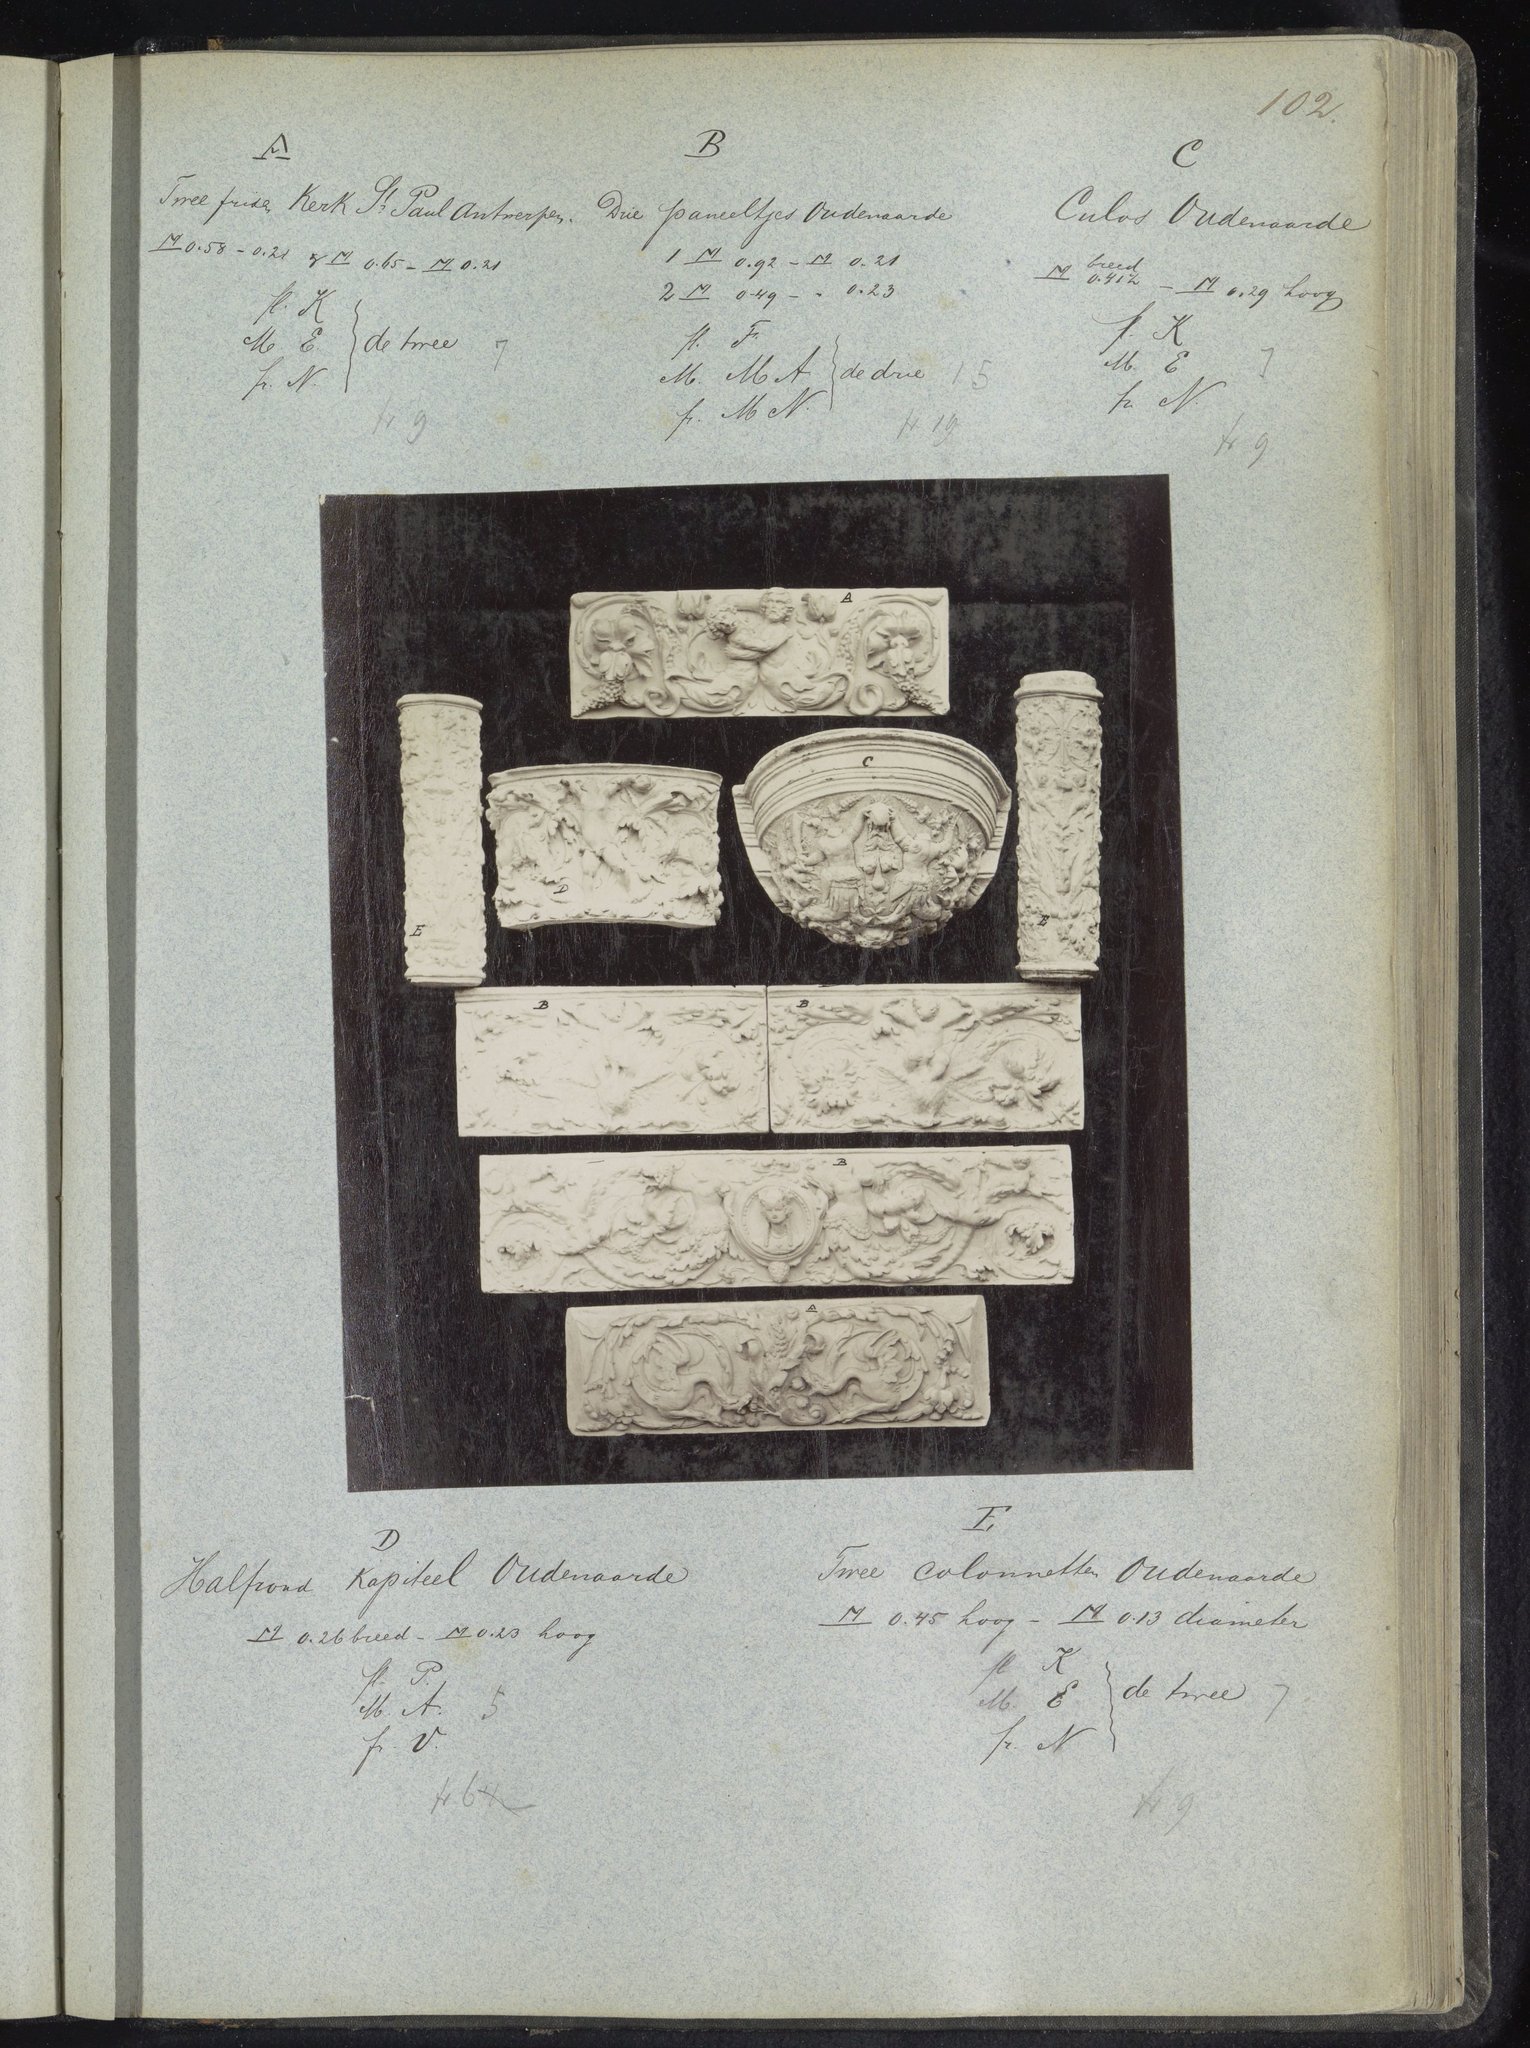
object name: album leaf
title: Gipsen afgietsels van onder meer paneeltjes, friezen, colonetten en en een kapiteel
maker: Anonymous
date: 1875-1900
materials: paper, photographic support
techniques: albumen print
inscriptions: annotation, annotation